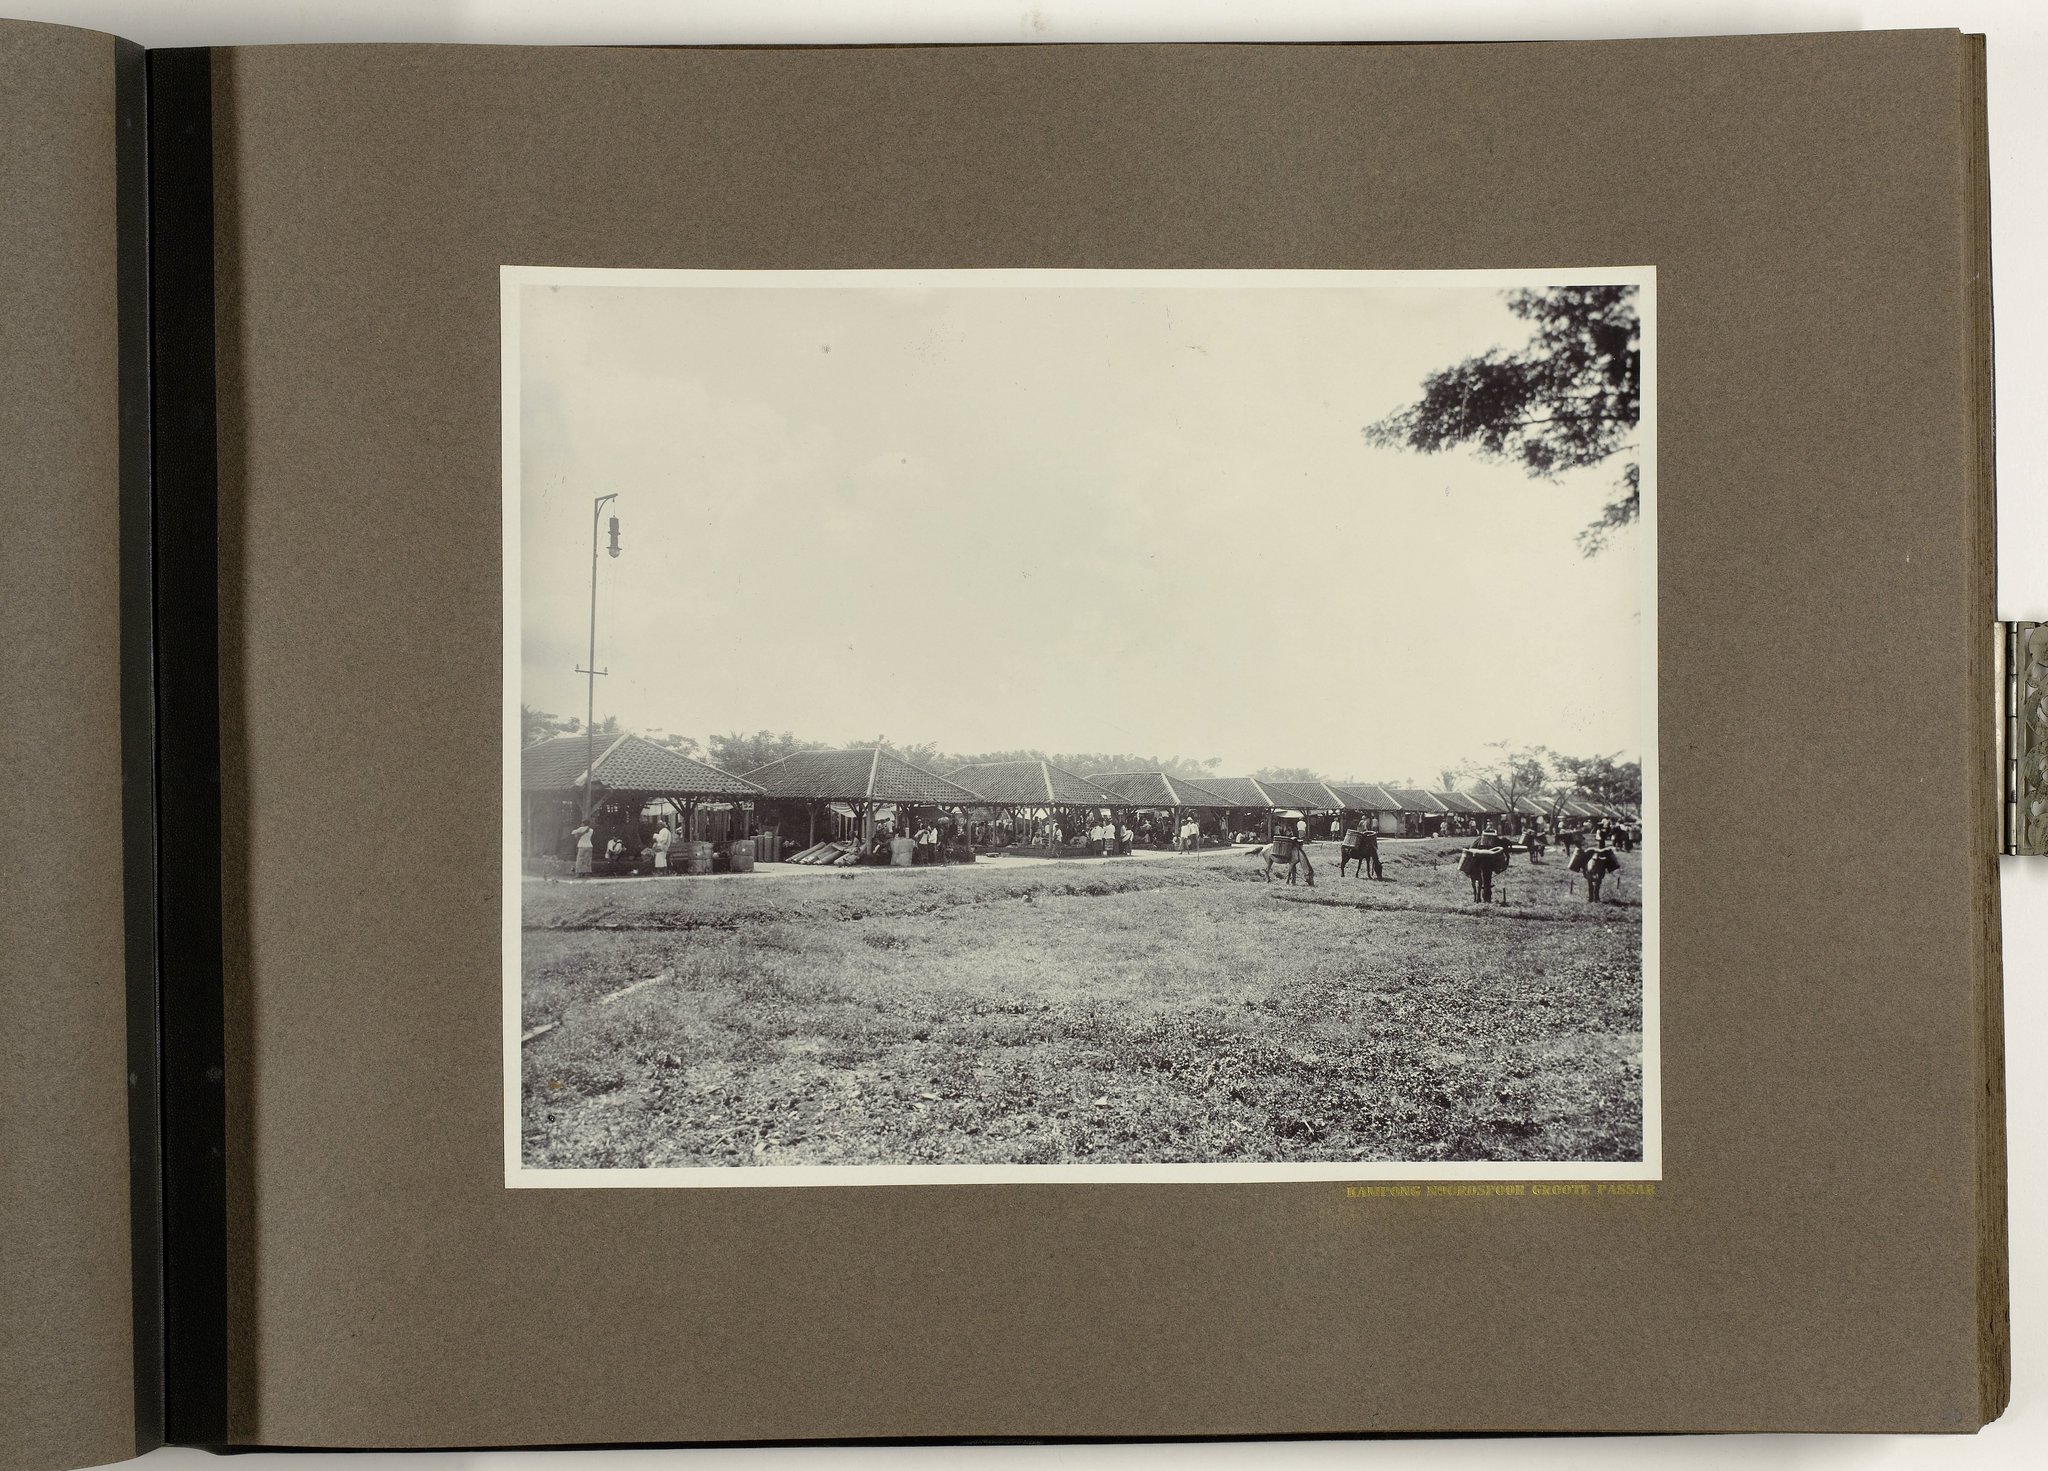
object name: photograph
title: Kampong noordspoor groote passar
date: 1917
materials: photographic support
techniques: gelatin silver print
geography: jatiroto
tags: colonial system, prospect of village, silhouette of village, (non-fruit) products of plants or trees: sugarcane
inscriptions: inscription: ‘KAMPONG NOORDSPOOR GROOTE PASSAR’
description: Terrein met marktstallen, op de voorgrond een grasveld met beladen grazende ezels. Bij het dorp van de werknemers van de suikerfabriek. Onderdeel van het fotoalbum aangeboden aan F.J. Wirix door het personeel van de Suikeronderneming Djatiroto in 1917.